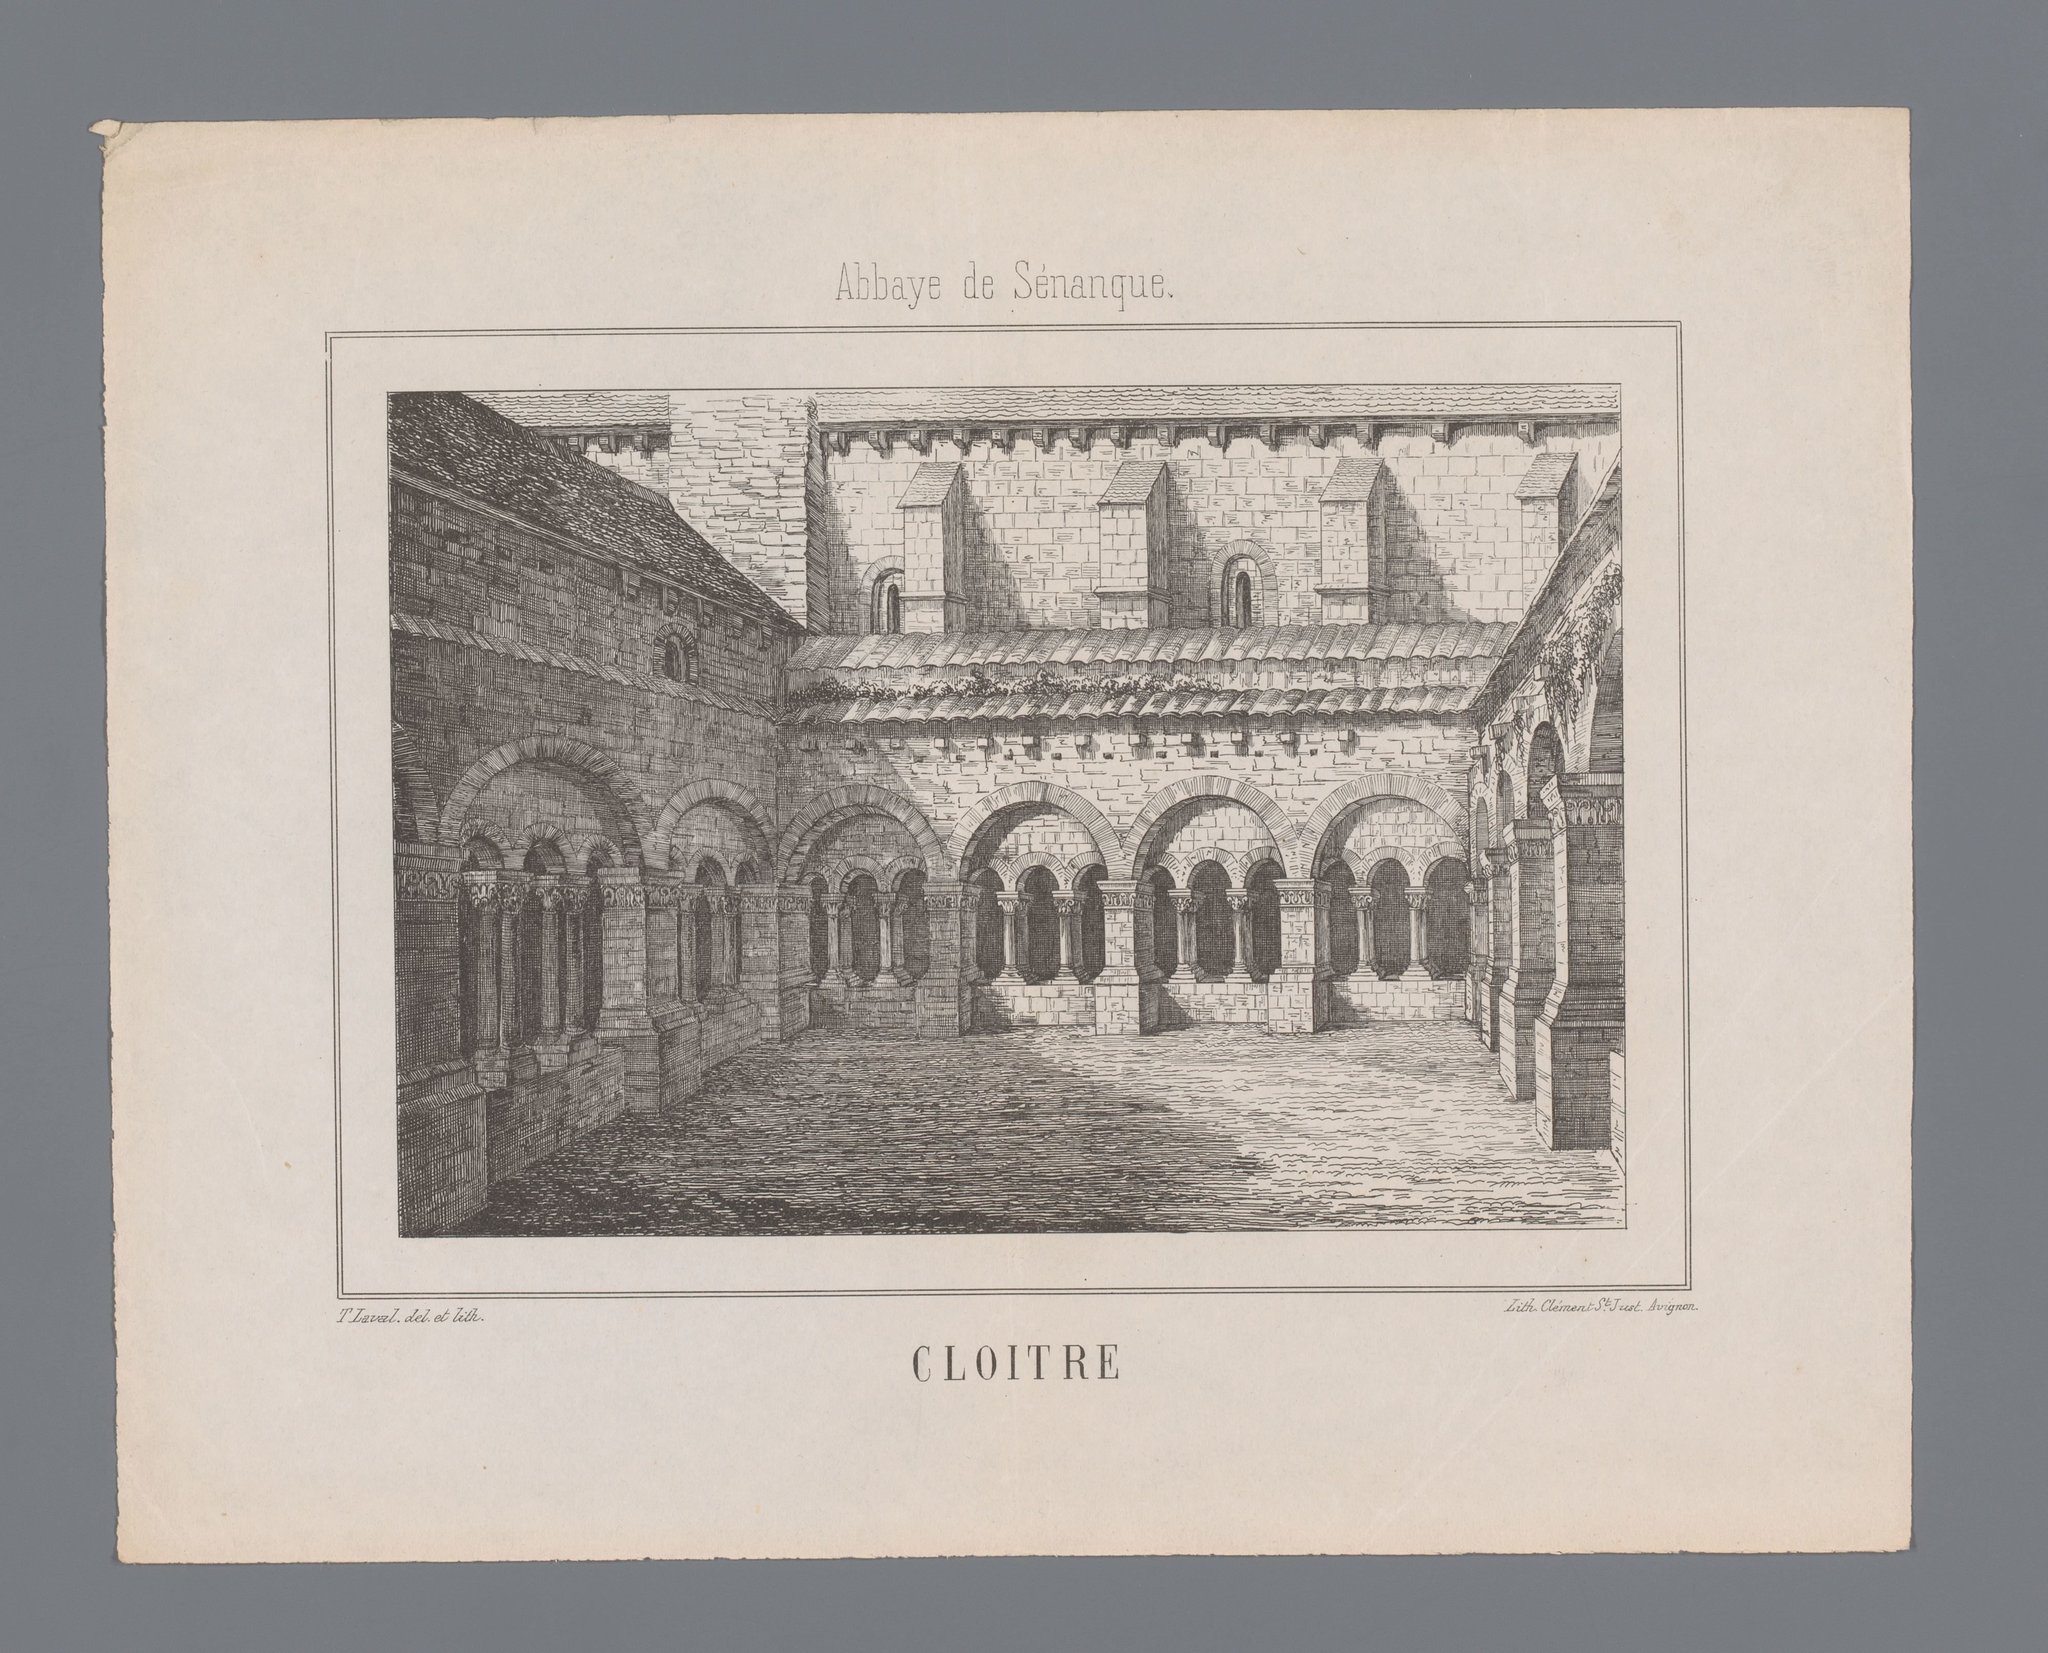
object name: print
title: Abbaye de Sénanque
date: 1855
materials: paper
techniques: lithograph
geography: avignon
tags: cloisters ~ monastery